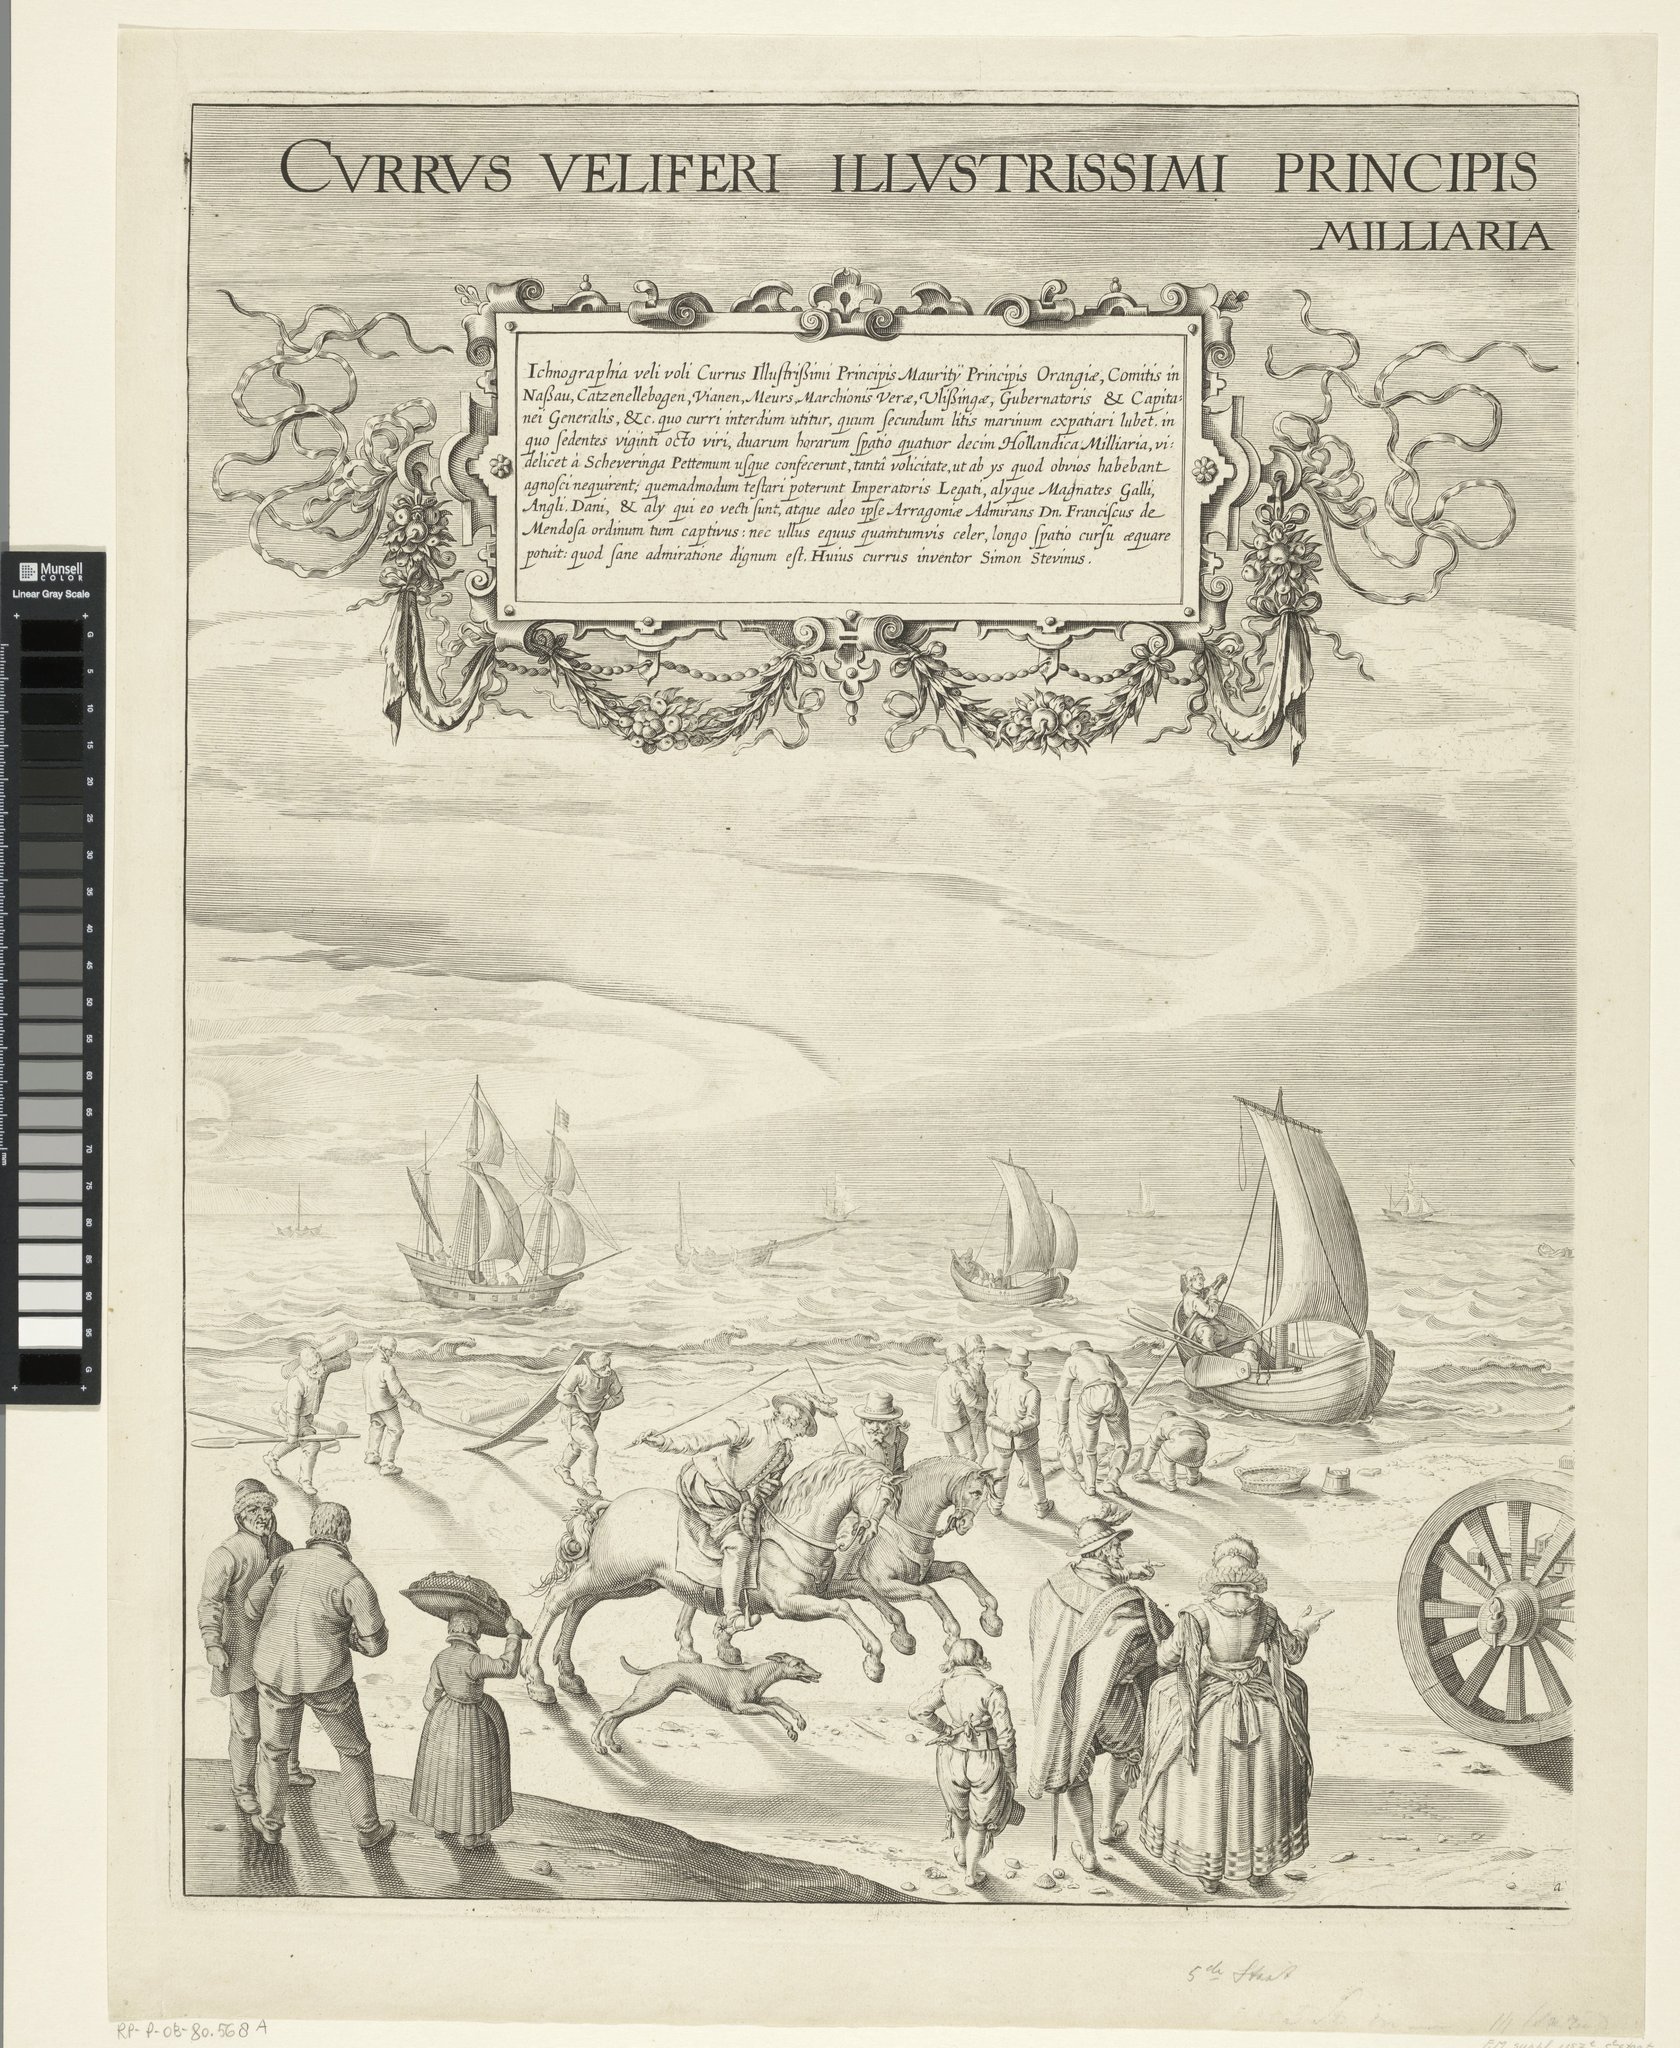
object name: history print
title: Currus veliferi illustrissimi principis Mauritii volitantes duabus horis Scheverina Pettemum ad quatuordecim milliaria Hollandica, quae singula iustae horae iter excedunt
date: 1603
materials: paper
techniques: engraving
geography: leiden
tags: maurice (prince of orange), bruges, simon stevin, sailing-car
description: De zeilwagen van Simon Stevin (linkerplaat), 1602. Prins Maurits maakt samen met een groep vrienden een tocht over het strand van Scheveningen naar Petten in de zeilwagen gebouwd door Simon Stevin, april-mei 1602. De grote cartouche ingevuld met tekst in het Latijn. Op het strand toeschouwers, vissers en twee ruiters. Linkerplaat (genummerd a) van een grote voorstelling bestaande uit drie delen.